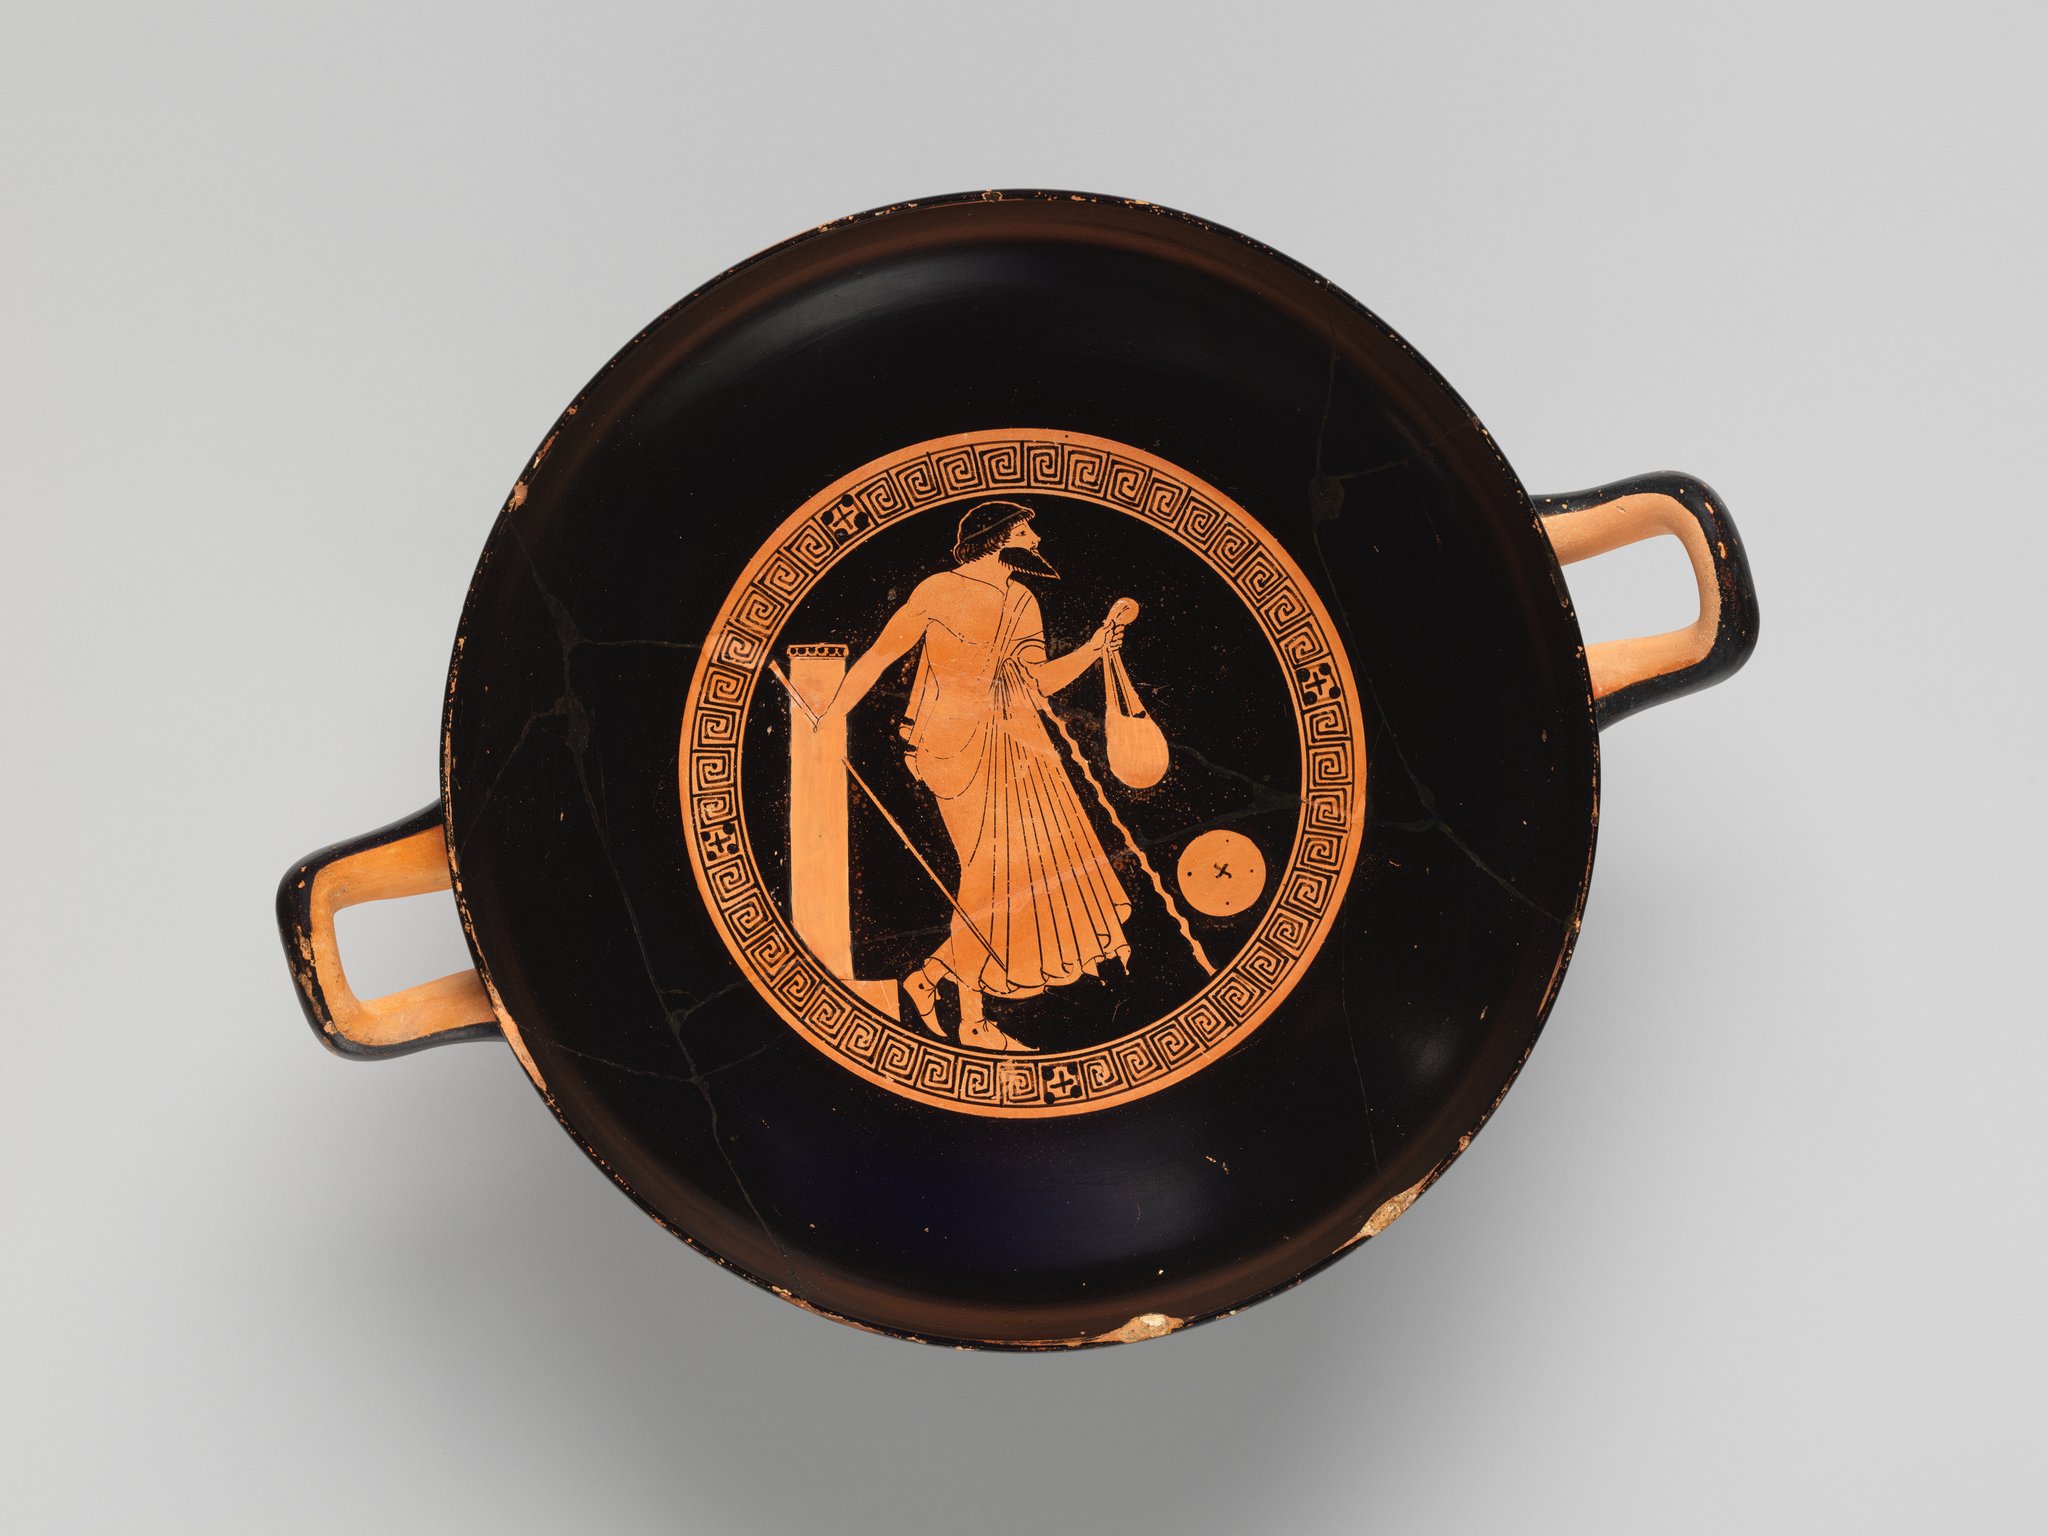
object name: kylix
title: Terracotta kylix (drinking cup)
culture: greek, attic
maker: brygos painter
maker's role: artist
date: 490-480 BCE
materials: terracotta